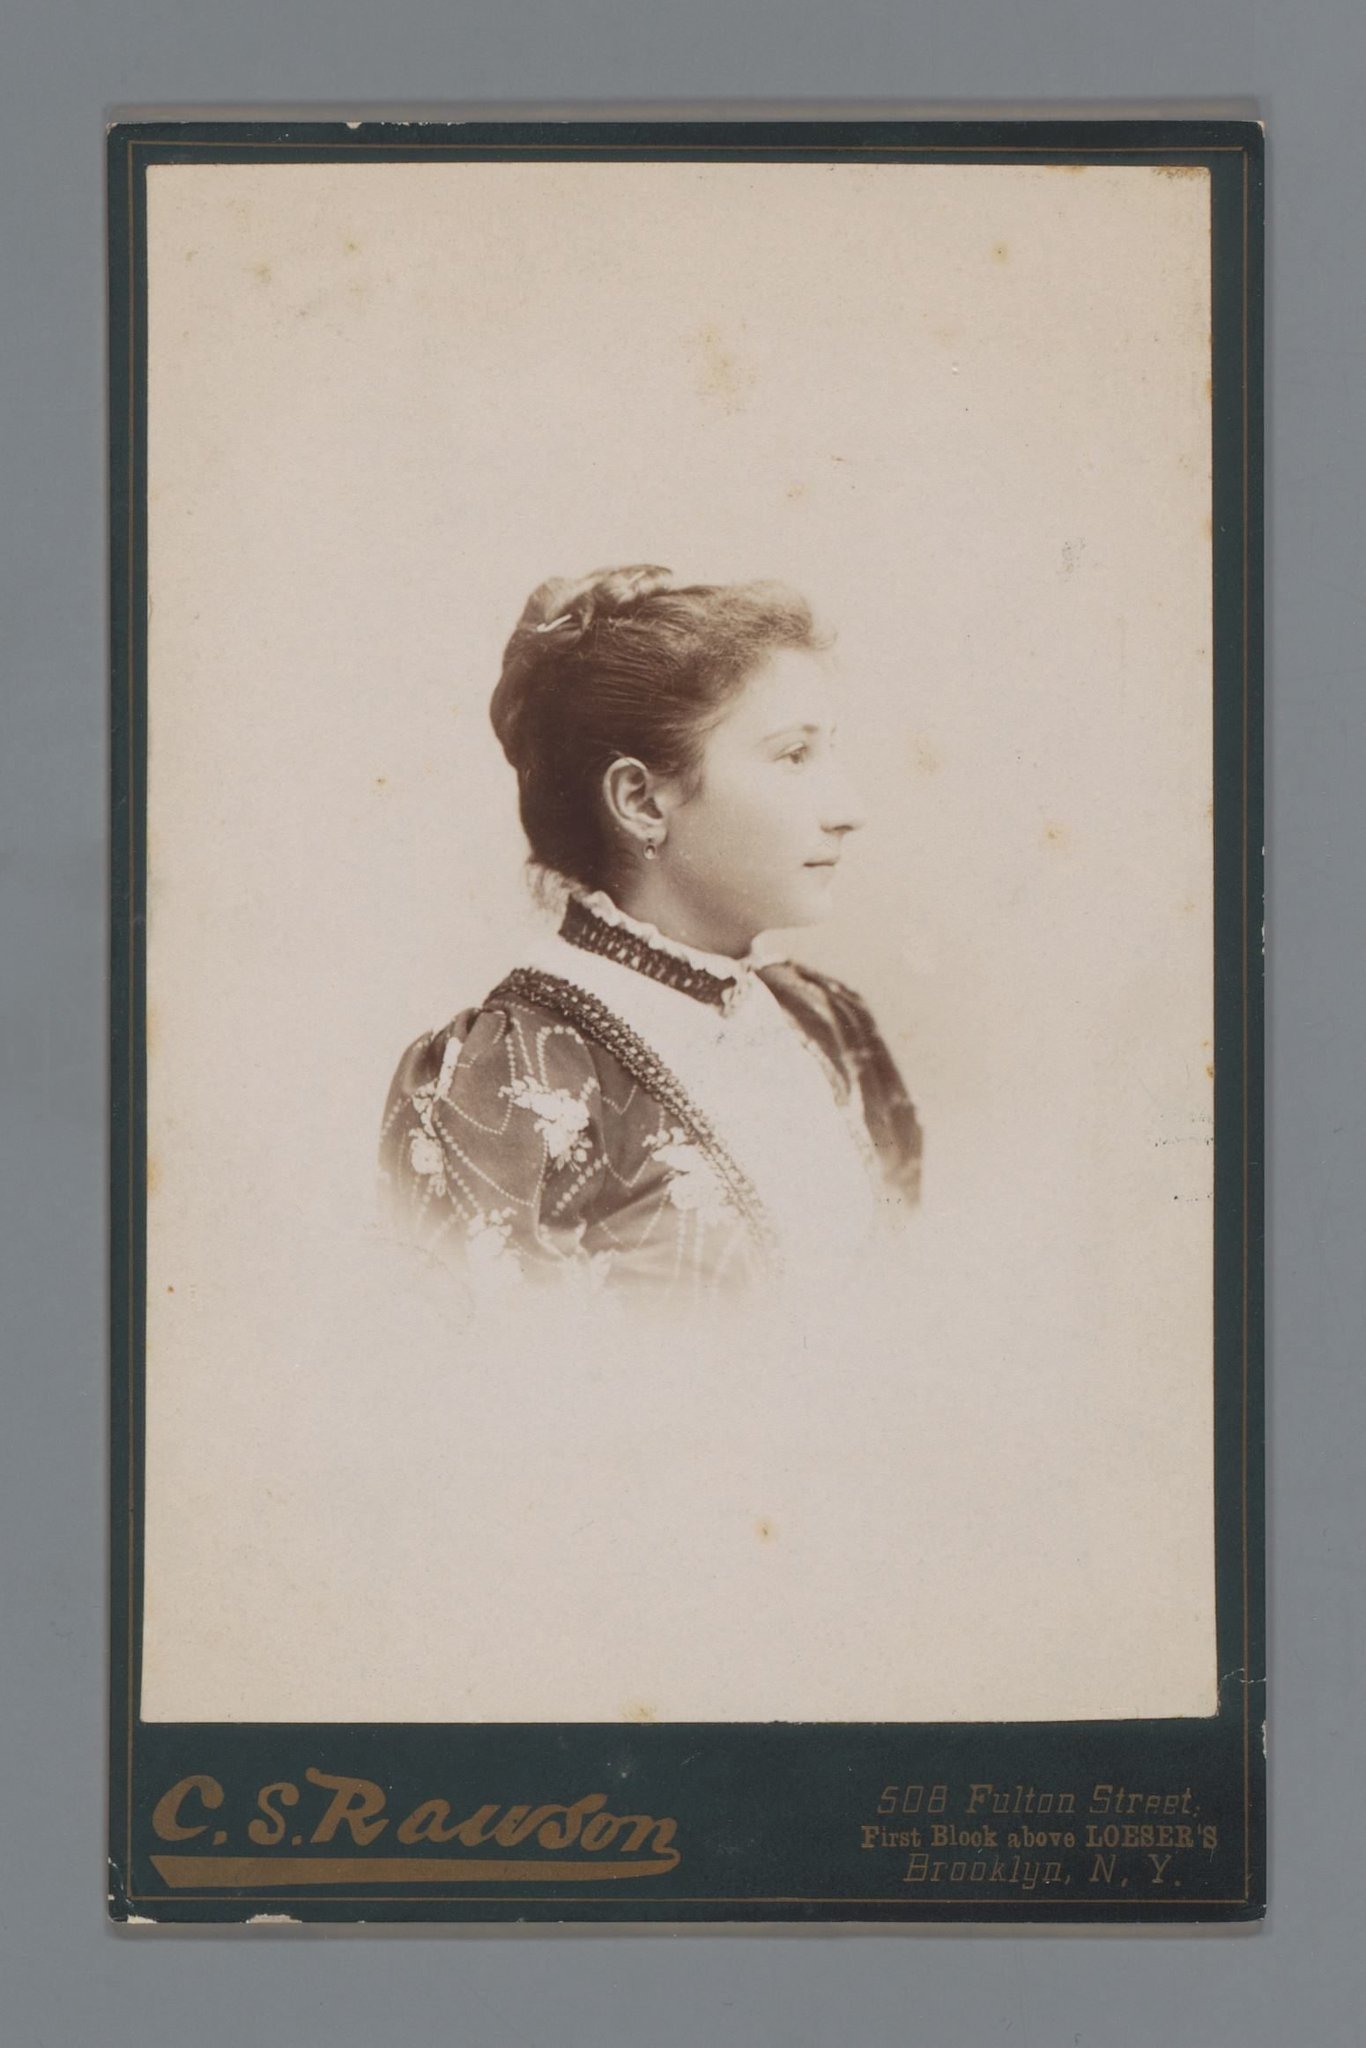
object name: photograph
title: Portret van een onbekende vrouw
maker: c.s. rawson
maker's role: fotograaf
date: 1875-1890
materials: cardboard, photographic support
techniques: albumen print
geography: new york city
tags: adult woman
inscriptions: name: ‘C.S. Rawson 508 Fulton Street, First Block above Loeser's Brooklyn, N.Y.’